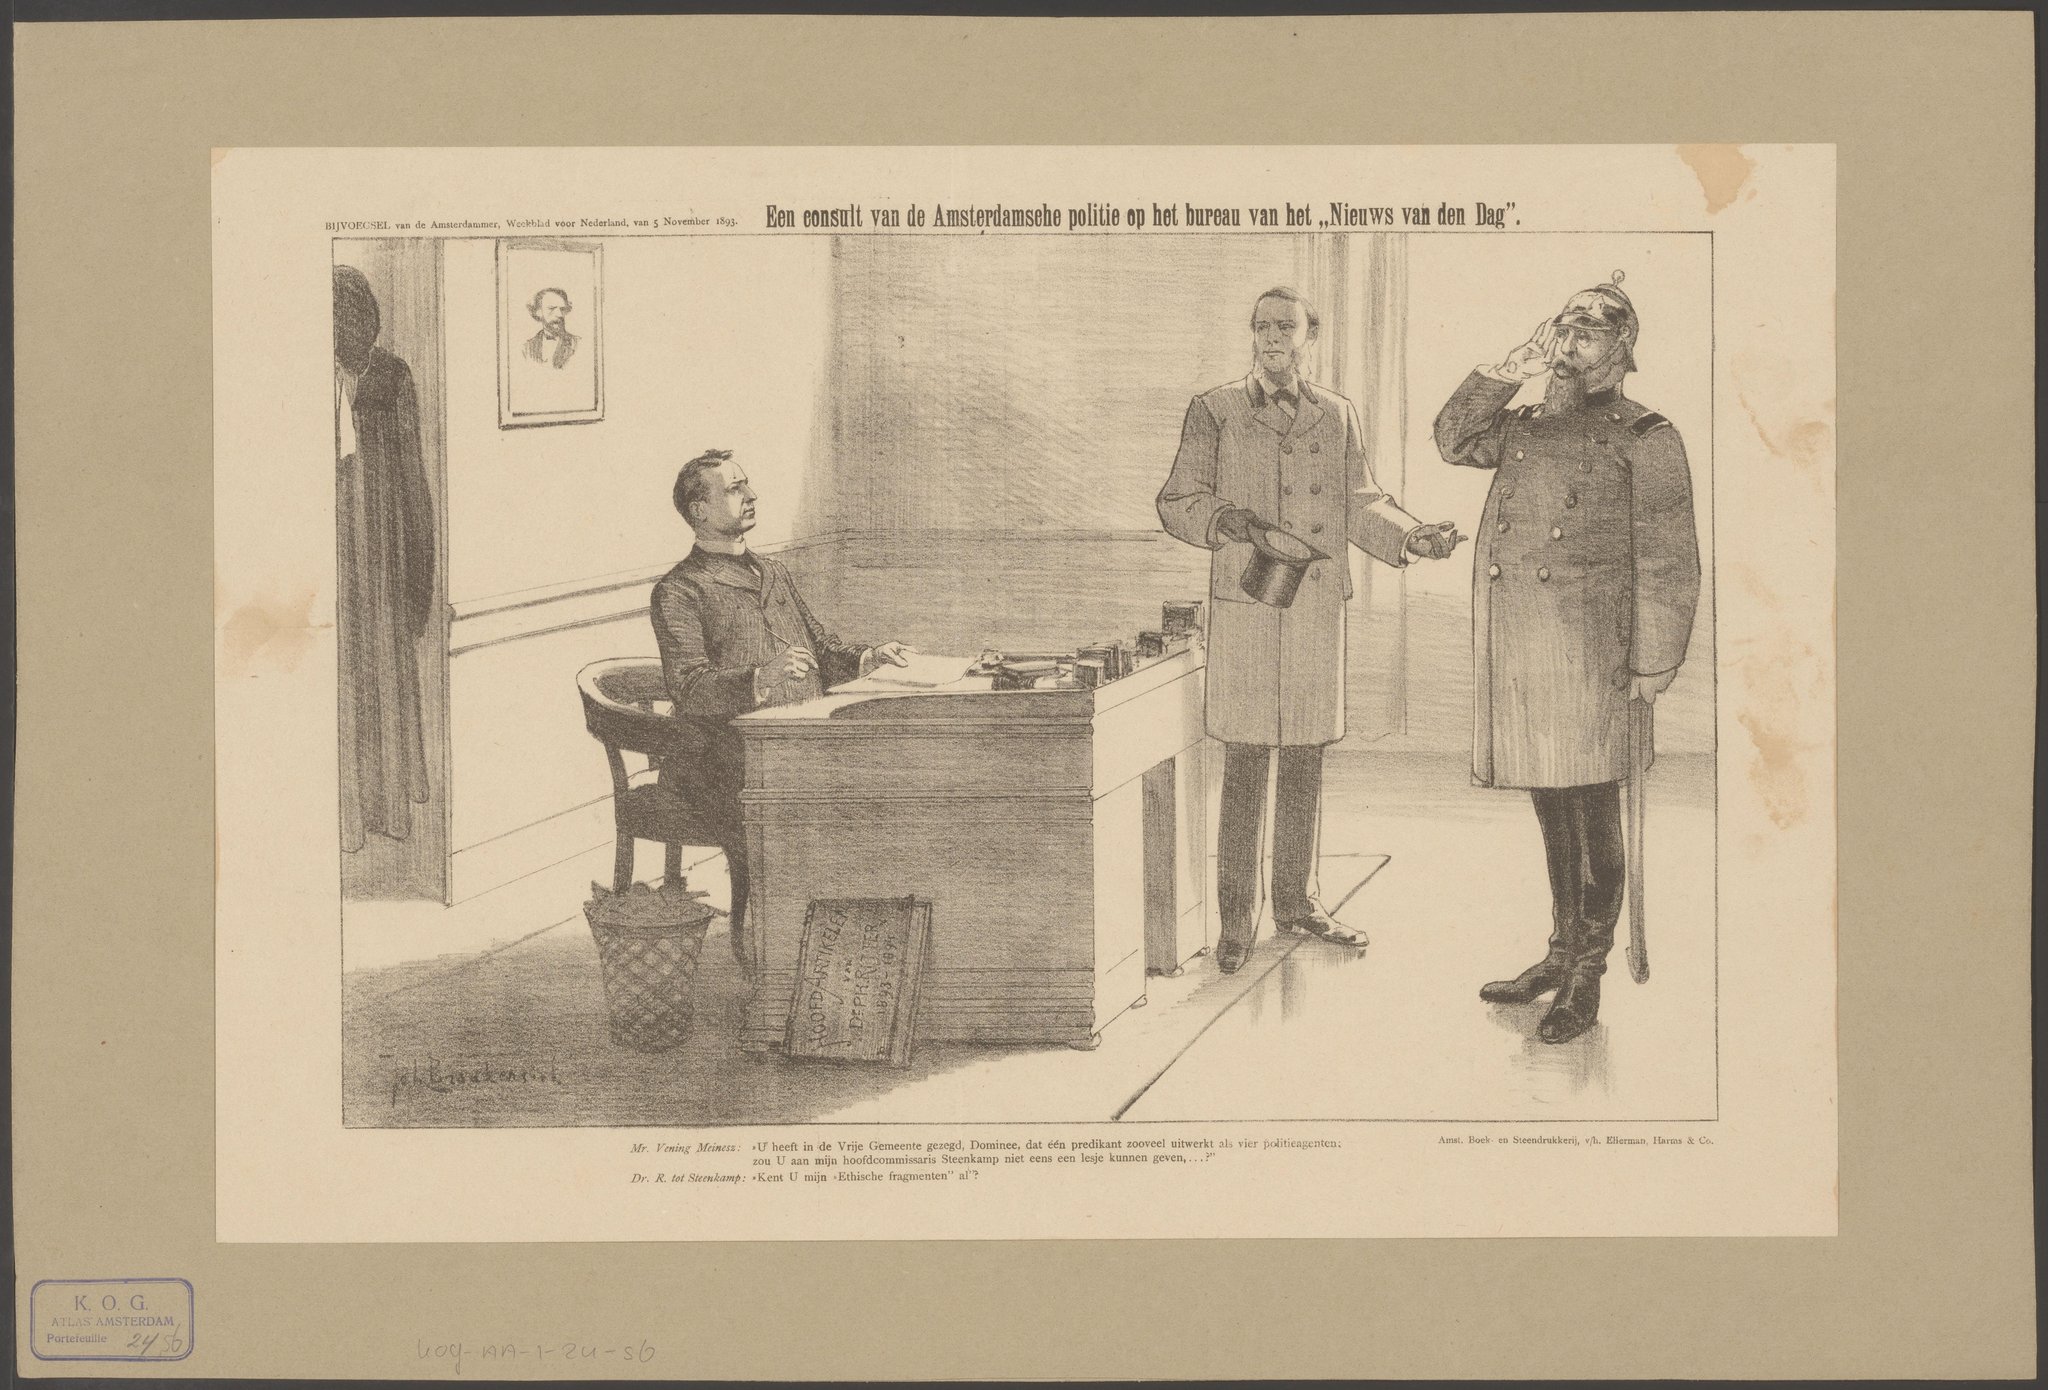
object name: cartoon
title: Een consult van de Amsterdamsche politie op het bureau van het "Nieuws van den Dag"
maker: johan braakensiek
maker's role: draughtsman, print maker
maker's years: 1858-1940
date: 1893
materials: paper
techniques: letterpress printing, lithograph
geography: amsterdam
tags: harlingen, politician, the hague, utrecht, pierre henri ritter, political caricatures and satires, police, amsterdam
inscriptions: collector's mark: Lugt 1641b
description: De Amsterdamse burgemeester Vening Meinesz met zijn hoofdcommissaris van politie Steenkamp op het kantoor van dominee Ritter, die schrijft voor de krant 'Het Nieuws van den Dag'. Onderwerpsrubriek binnen de Atlas Amsterdam: Politie.